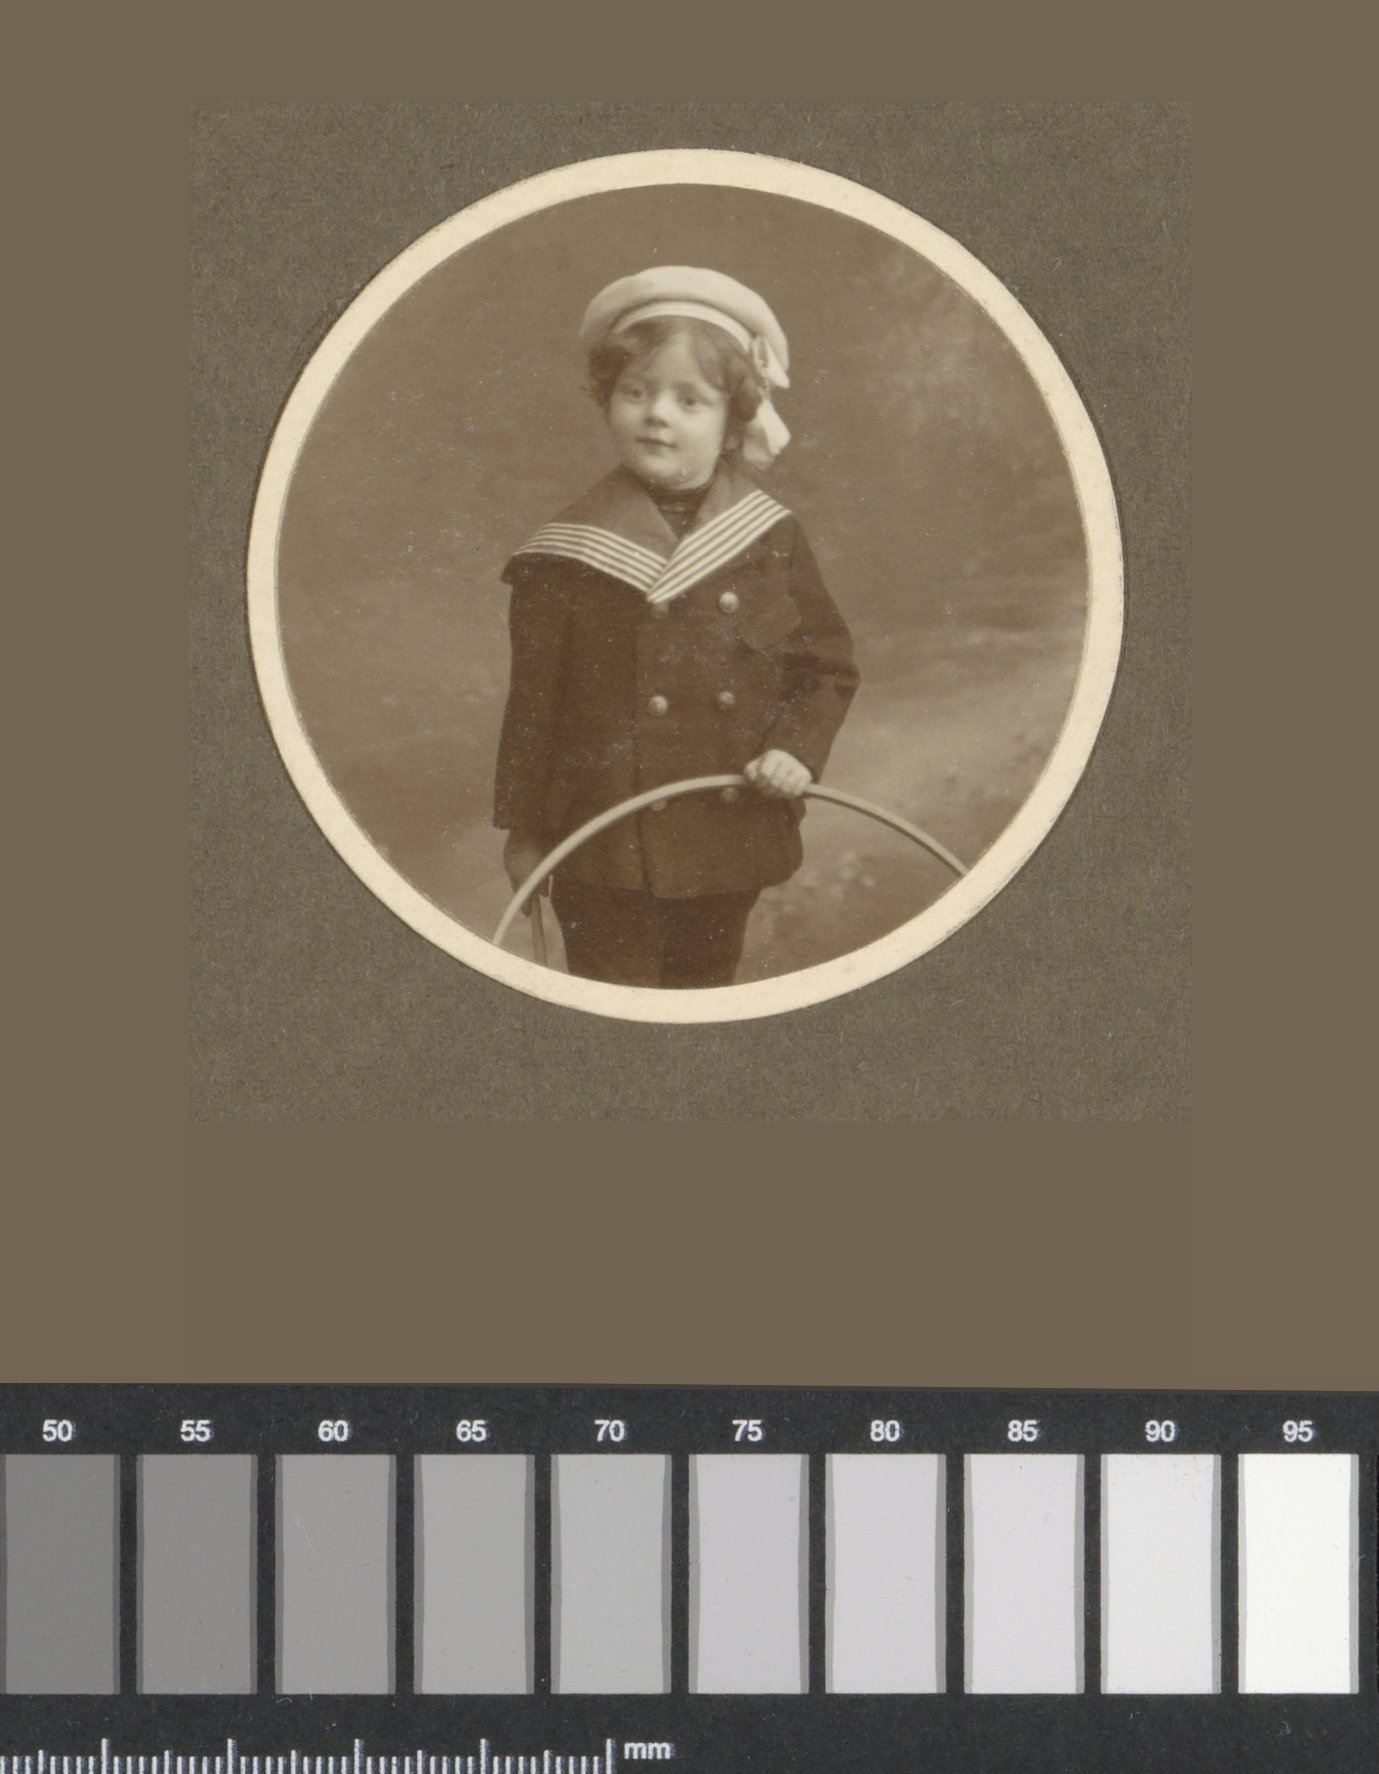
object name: photograph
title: Portret van een kind in een matrozenpak met hoepel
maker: cornelis johannes lodewicus vermeulen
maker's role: fotograaf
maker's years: 1861-1936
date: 1900-1920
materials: paper, photographic support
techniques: gelatin silver print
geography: the hague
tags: studio requisites ~ photographer, ensemble of pieces of clothing: sailor suit, child, (bowling a) hoop, the hague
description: Onderdeel van Fotoalbum met opnames van het gezin en het huis van fotograaf C.J.L. Vermeulen in Den Haag.